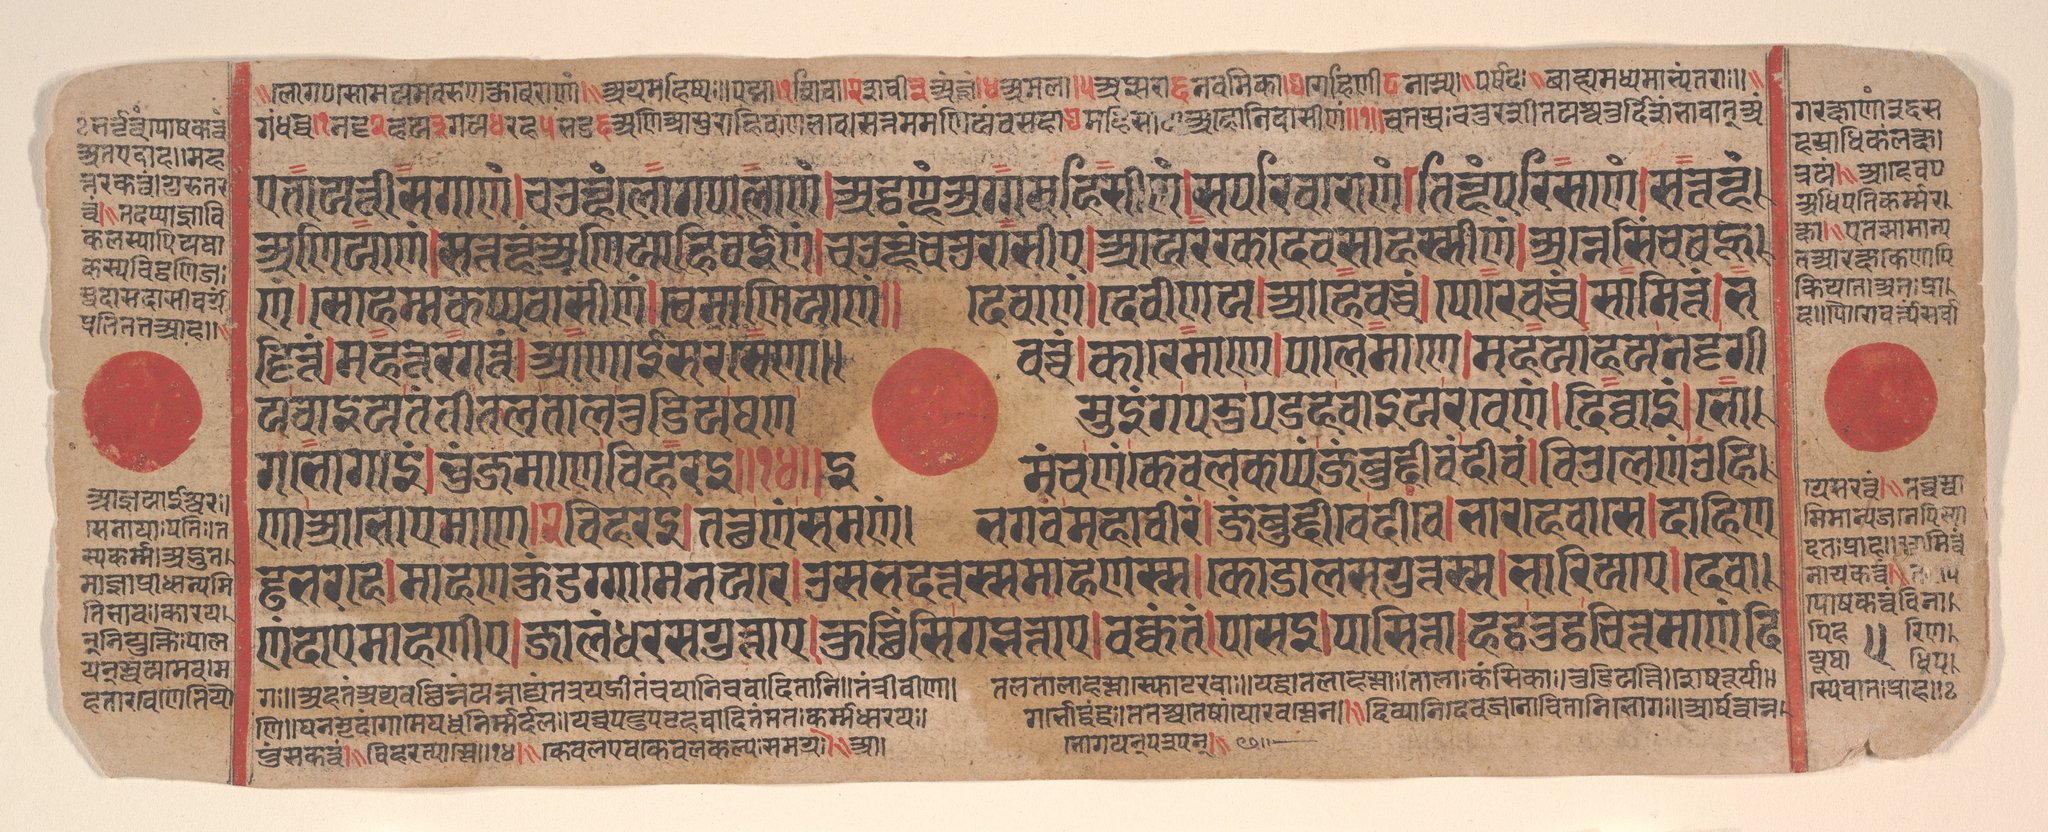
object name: folio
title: Leaf from a Kalpa Sutra (Jain Book of Rituals)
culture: indian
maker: bhadrabahu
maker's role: artist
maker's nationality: indian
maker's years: 356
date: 1401-1500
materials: gold, ink, paper, watercolor